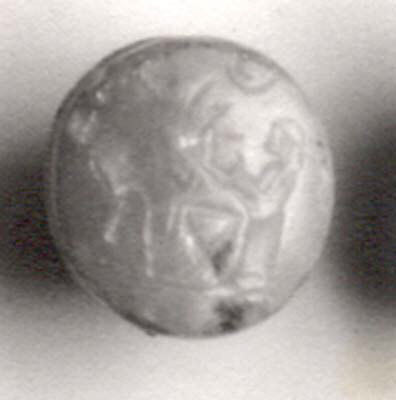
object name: stamp seal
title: Stamp seal (grooved circular base with loop handle) with cultic scene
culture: assyro-babylonian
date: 700-501 BCE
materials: stone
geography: northern syria or southeastern anatolia